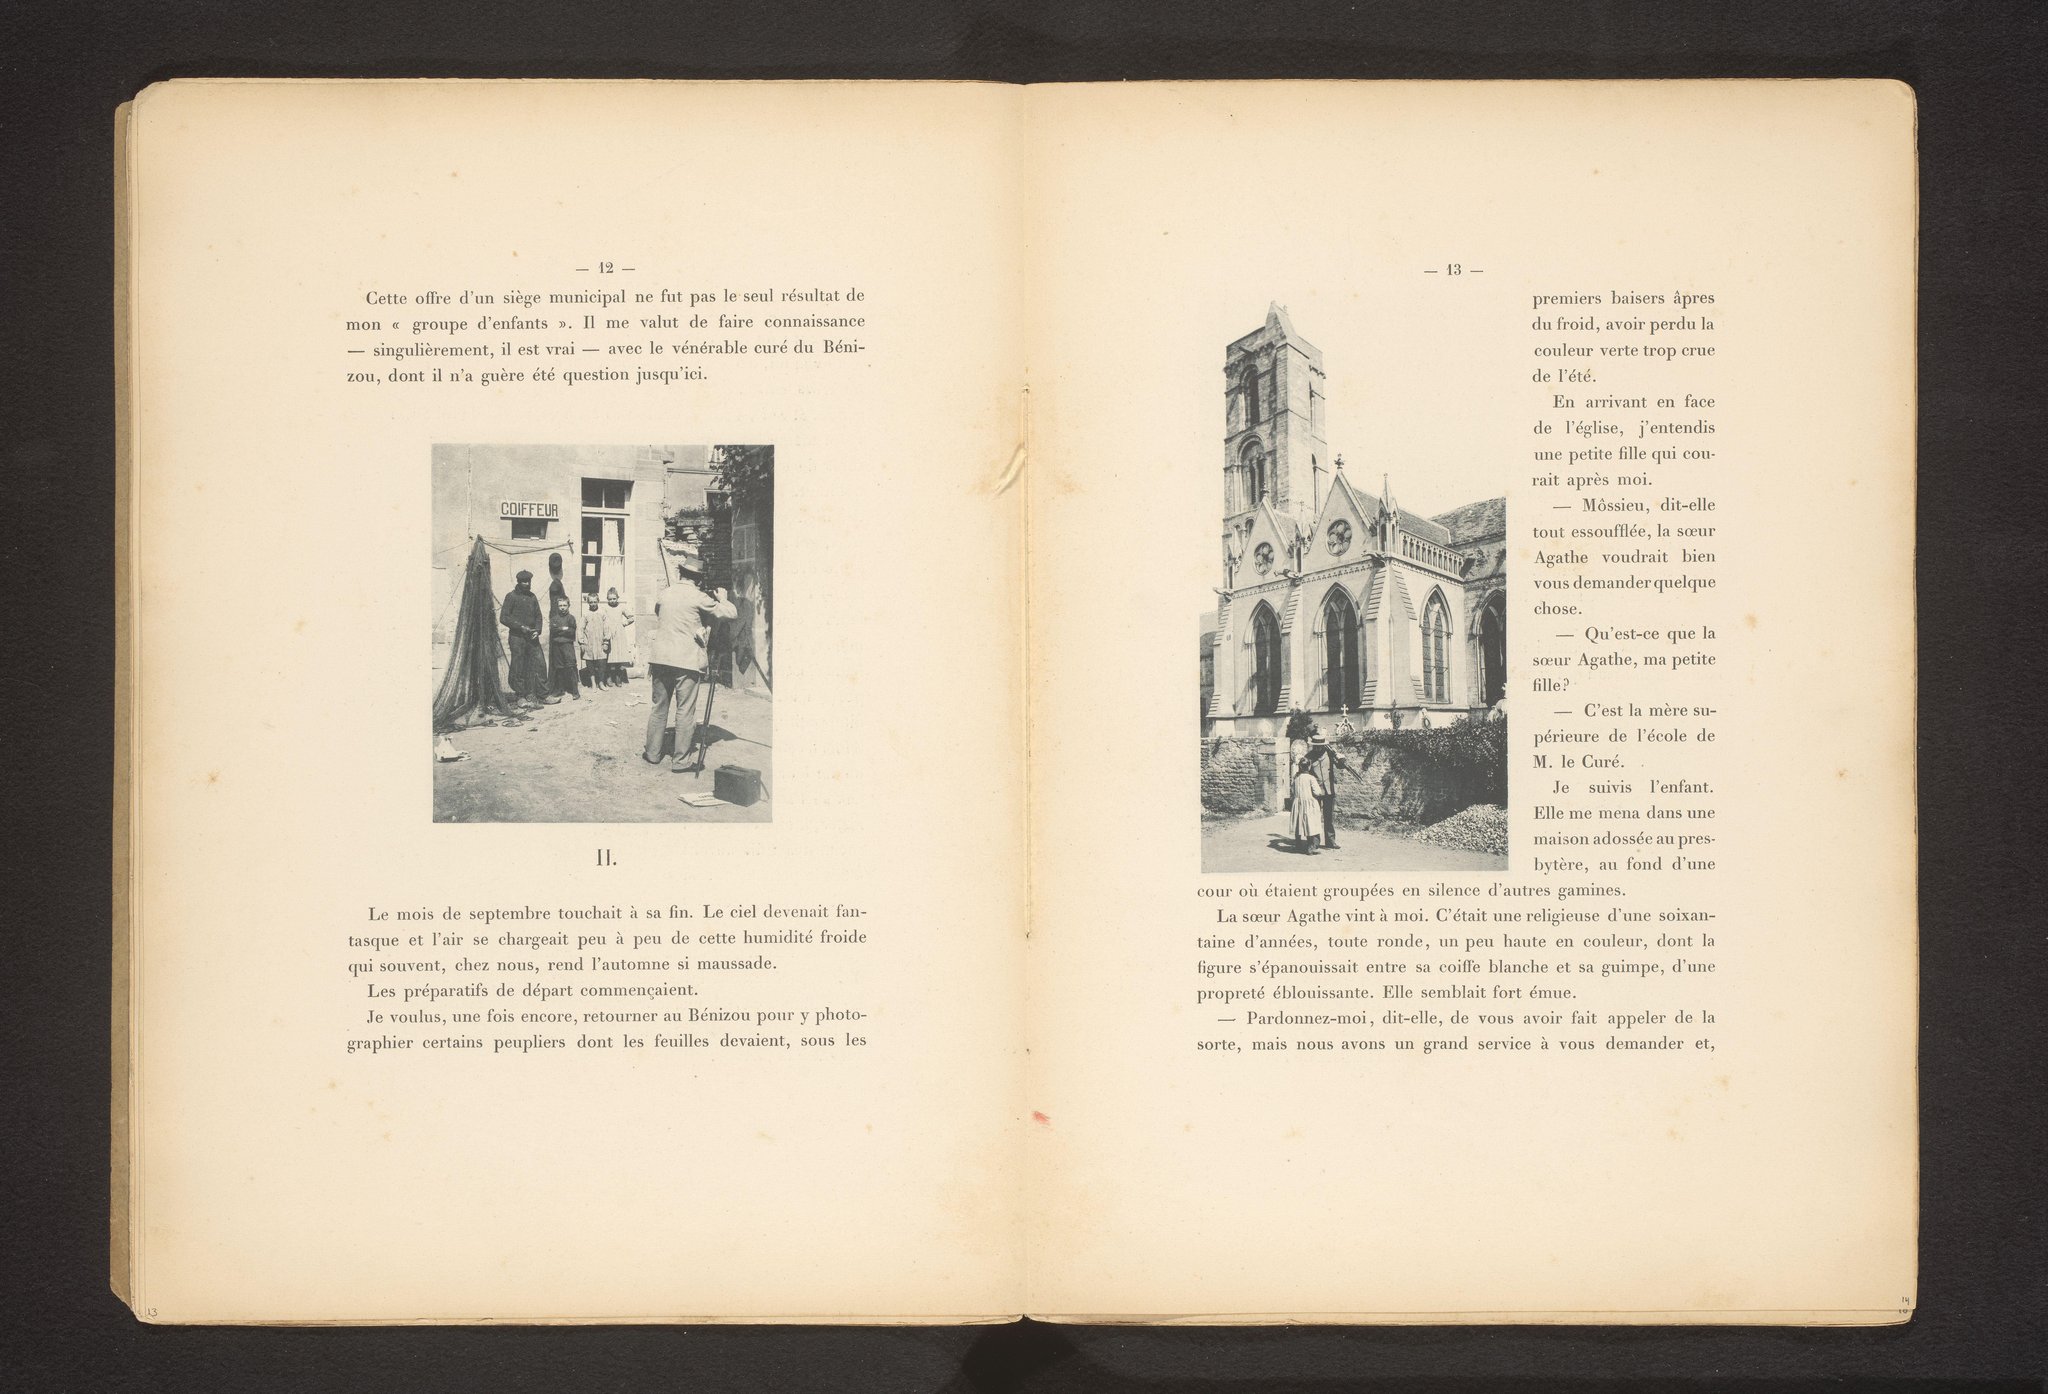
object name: page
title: Man en een meisje voor een kerk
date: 1885-1895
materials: paper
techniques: photograph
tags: camera ~ photography, church (exterior)